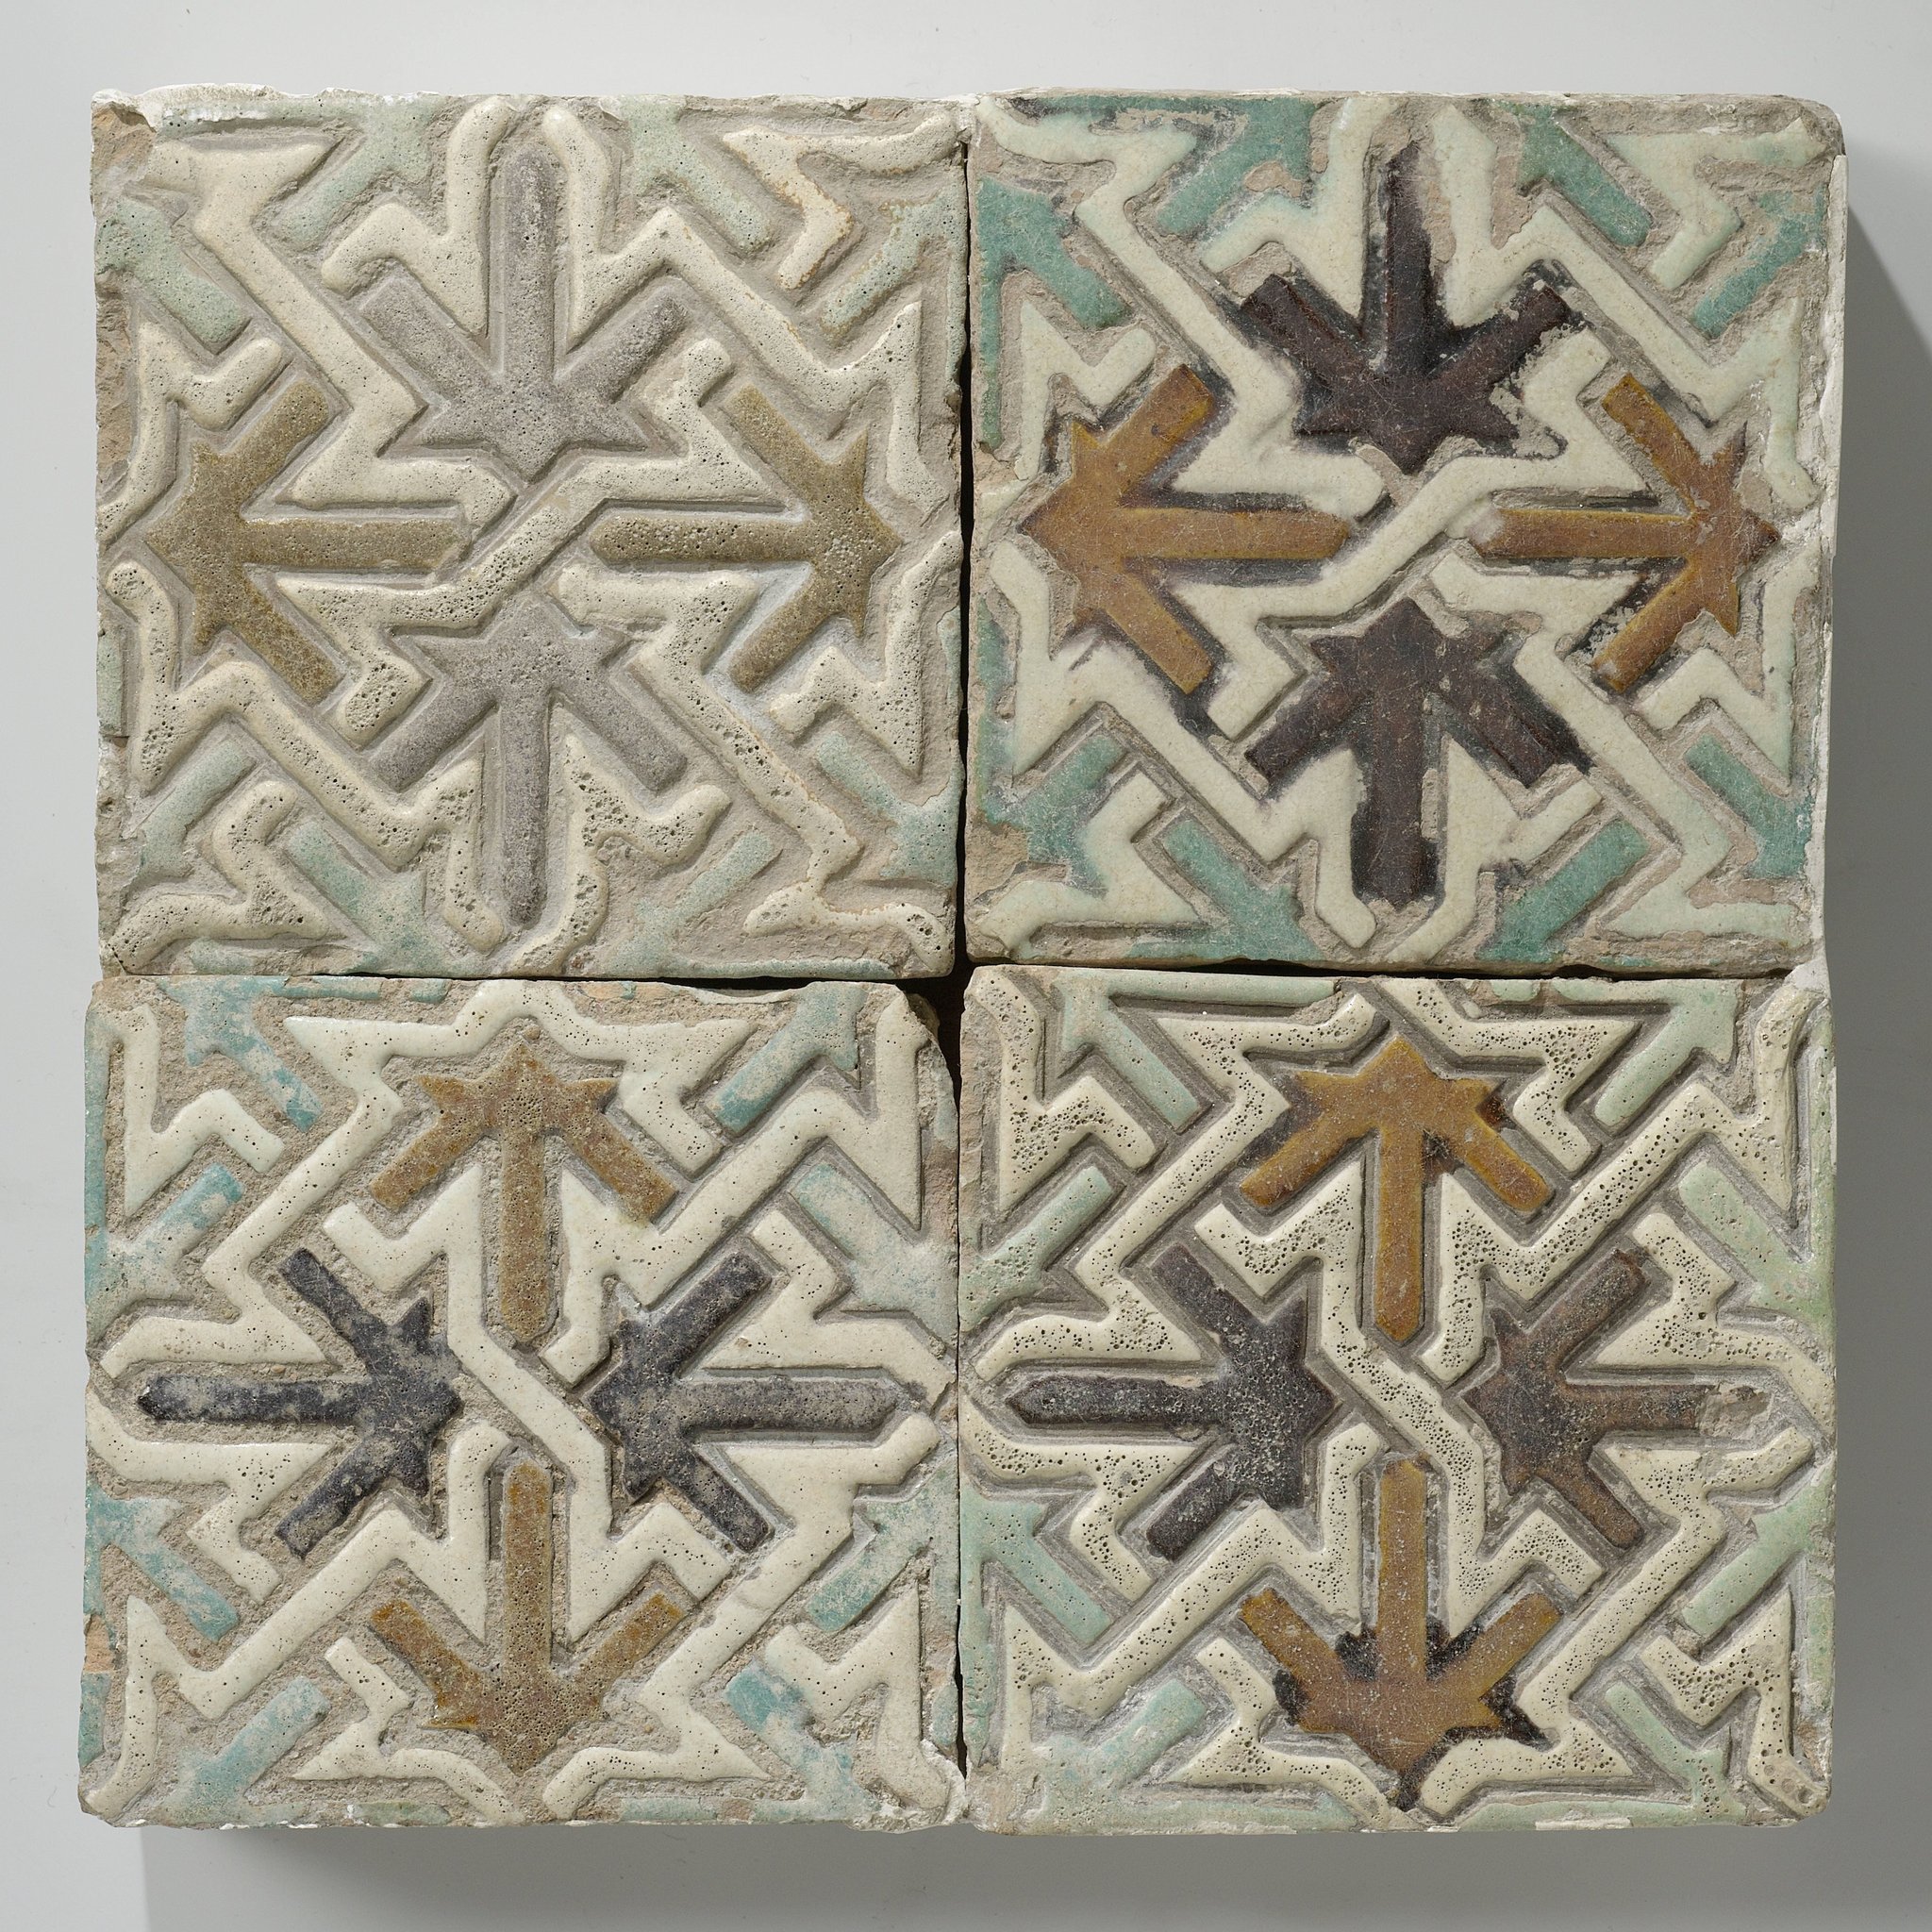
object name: tile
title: Tegel, veelkleurig versierd met een ornament van dooreen gevlochten sterren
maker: Anonymous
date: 1400-1600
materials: earthenware, glaze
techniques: lace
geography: spain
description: Tegel, veelkleurig versierd in cuenca-techniek met een ornament van dooreen gevlochten sterren.